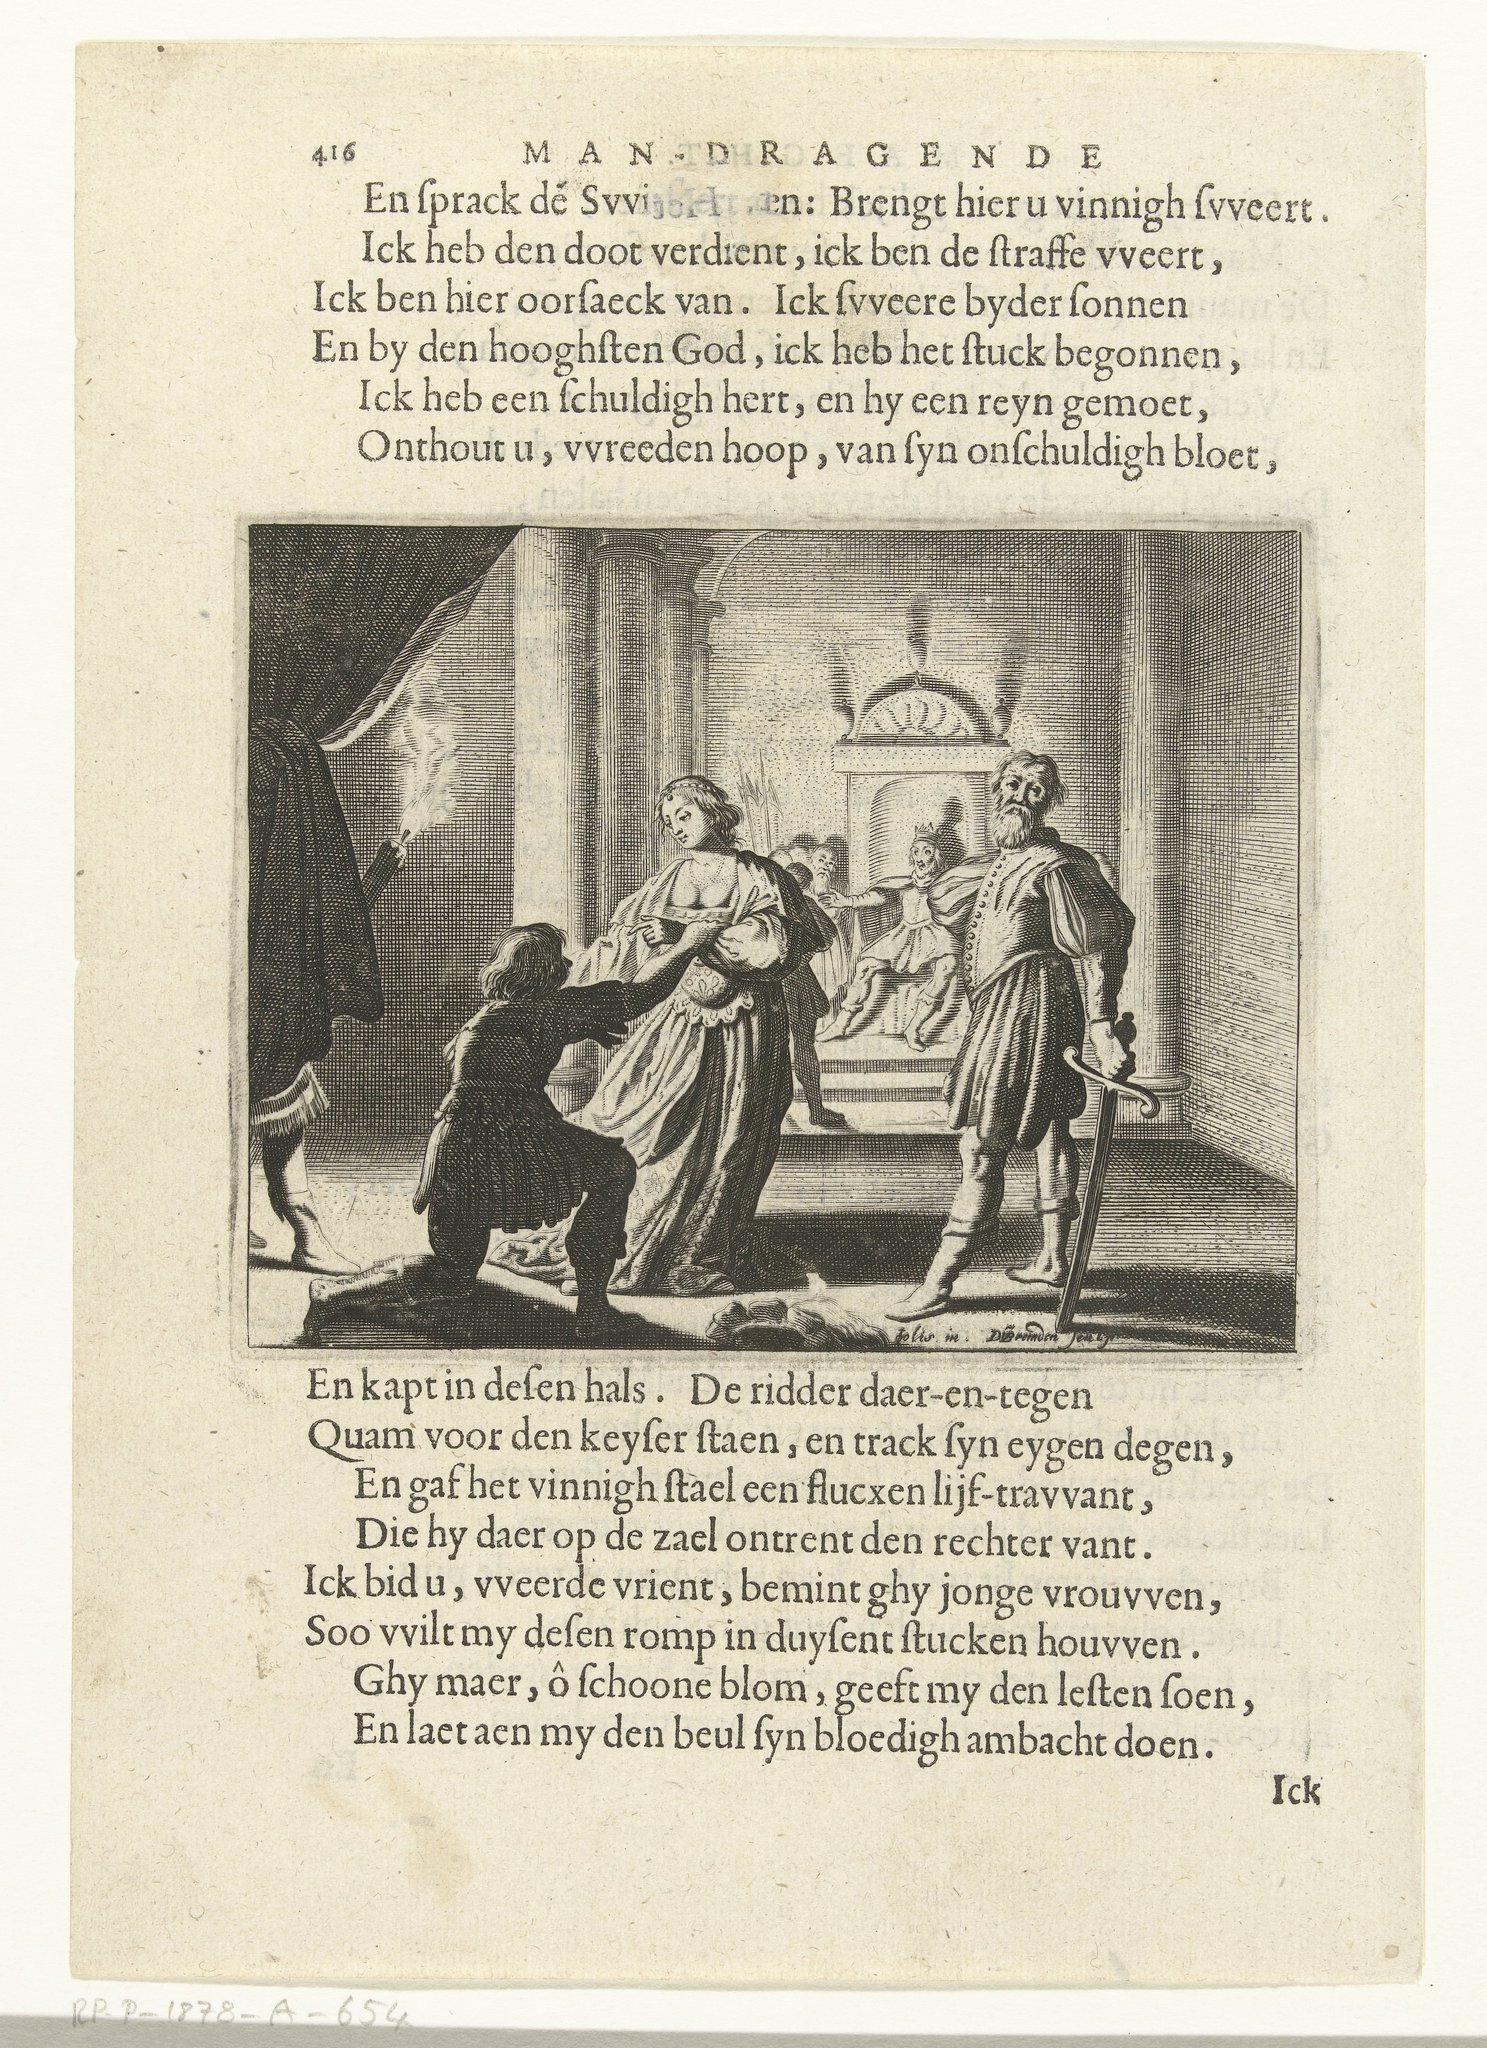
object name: book illustration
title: Emma en Einhart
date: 1537-1635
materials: paper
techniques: engraving, letterpress printing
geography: amsterdam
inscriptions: collector's mark: Lugt 2228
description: Emma de dochter van keizer Karel, en Einhart zijn secretaris staan voor de rechterstoel van Karel. Einhart knielt voor Emma. Een ridder met zwaard staat naast het paar. Bladzijde uit een boek met tekst op recto en verso.